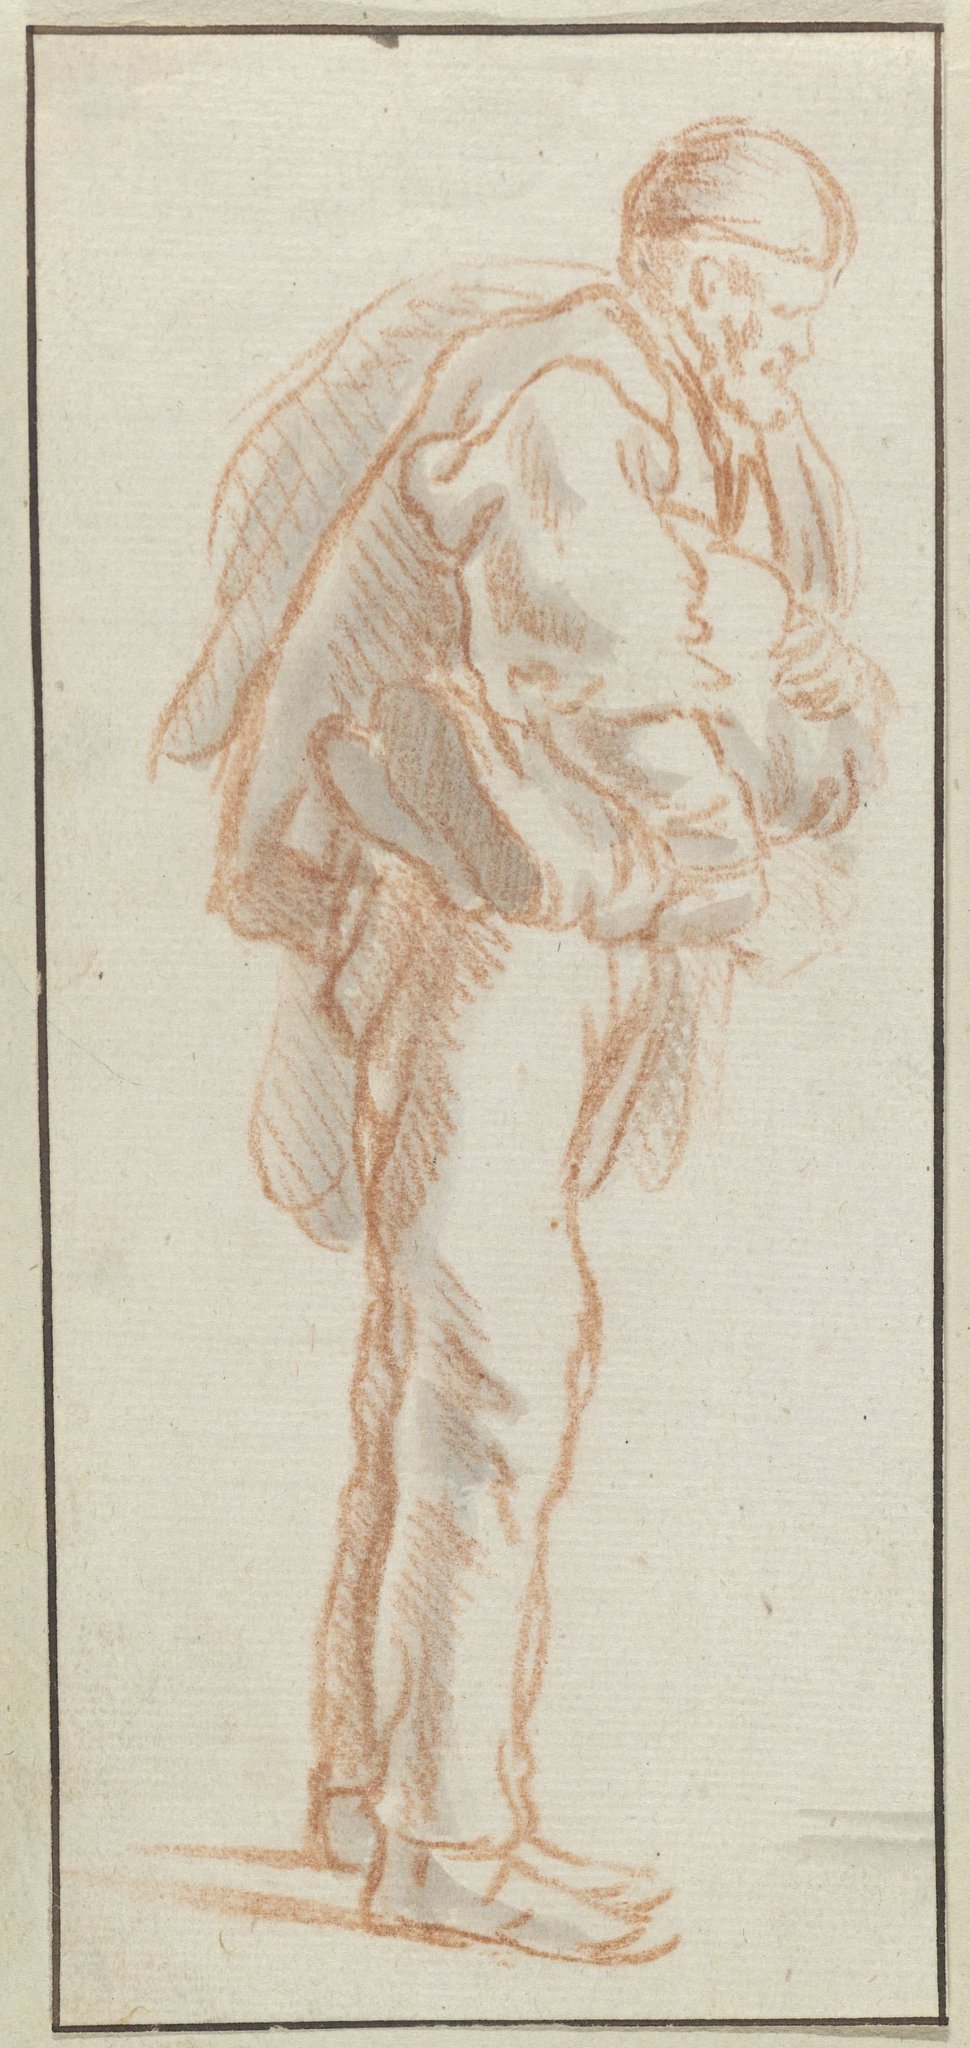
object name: drawing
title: Staande man met spullen over zijn schouder en onder zijn arm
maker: Anonymous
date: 1700-1799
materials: chalk, paper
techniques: brush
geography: netherlands